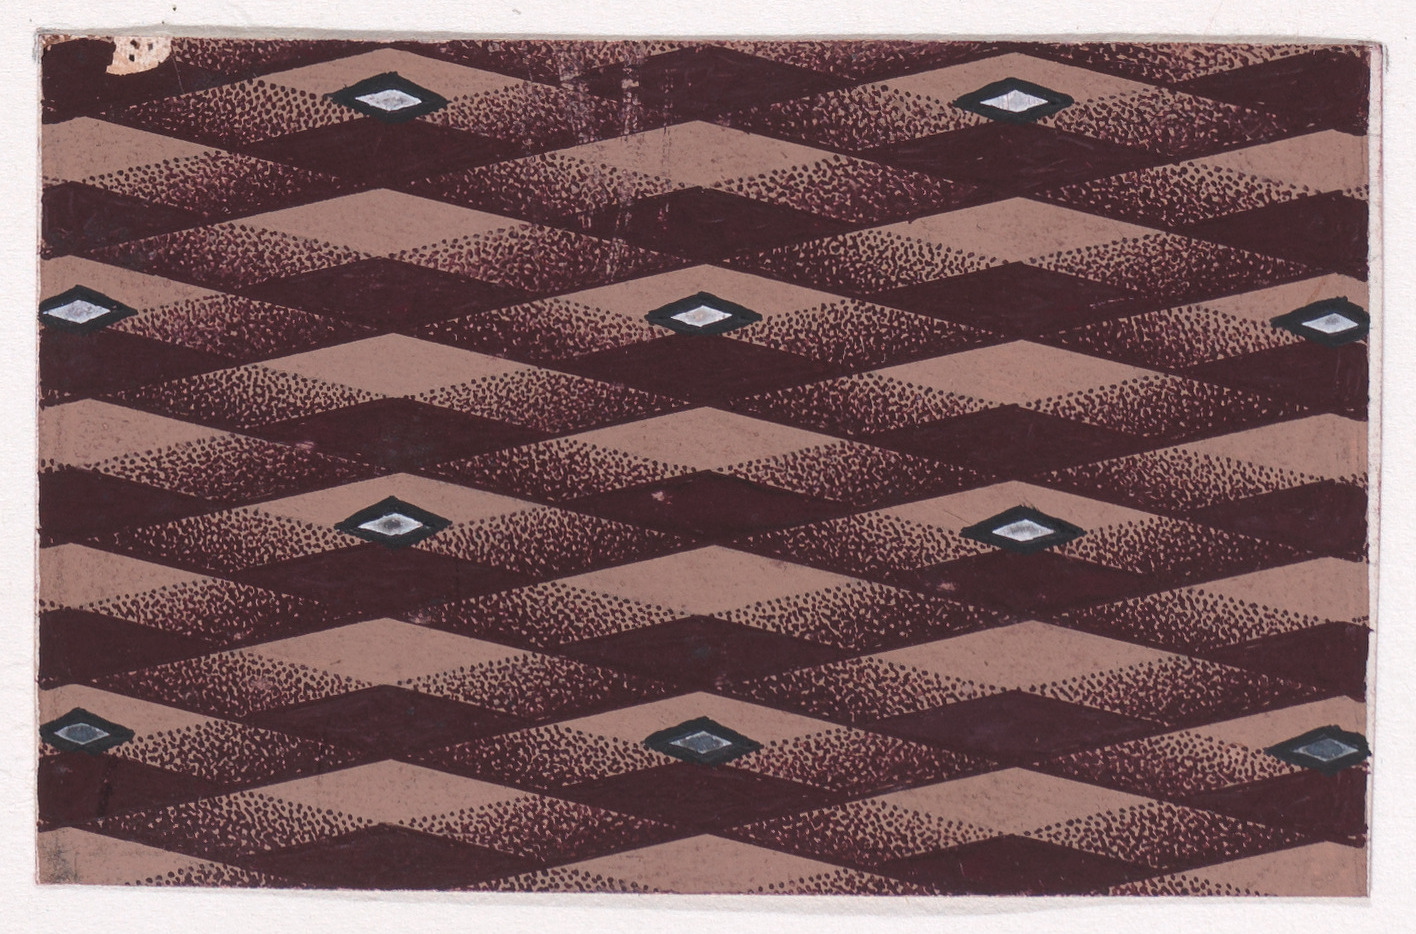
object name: drawing ornament architecture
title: Textile Design with Alternating Vertical Rows of Lozenges over a Background of Intersecting Diagonal Ribbons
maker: anonymous, alsatian, 19th century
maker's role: artist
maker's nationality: alsatian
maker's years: 1800-1900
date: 1840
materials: gouache